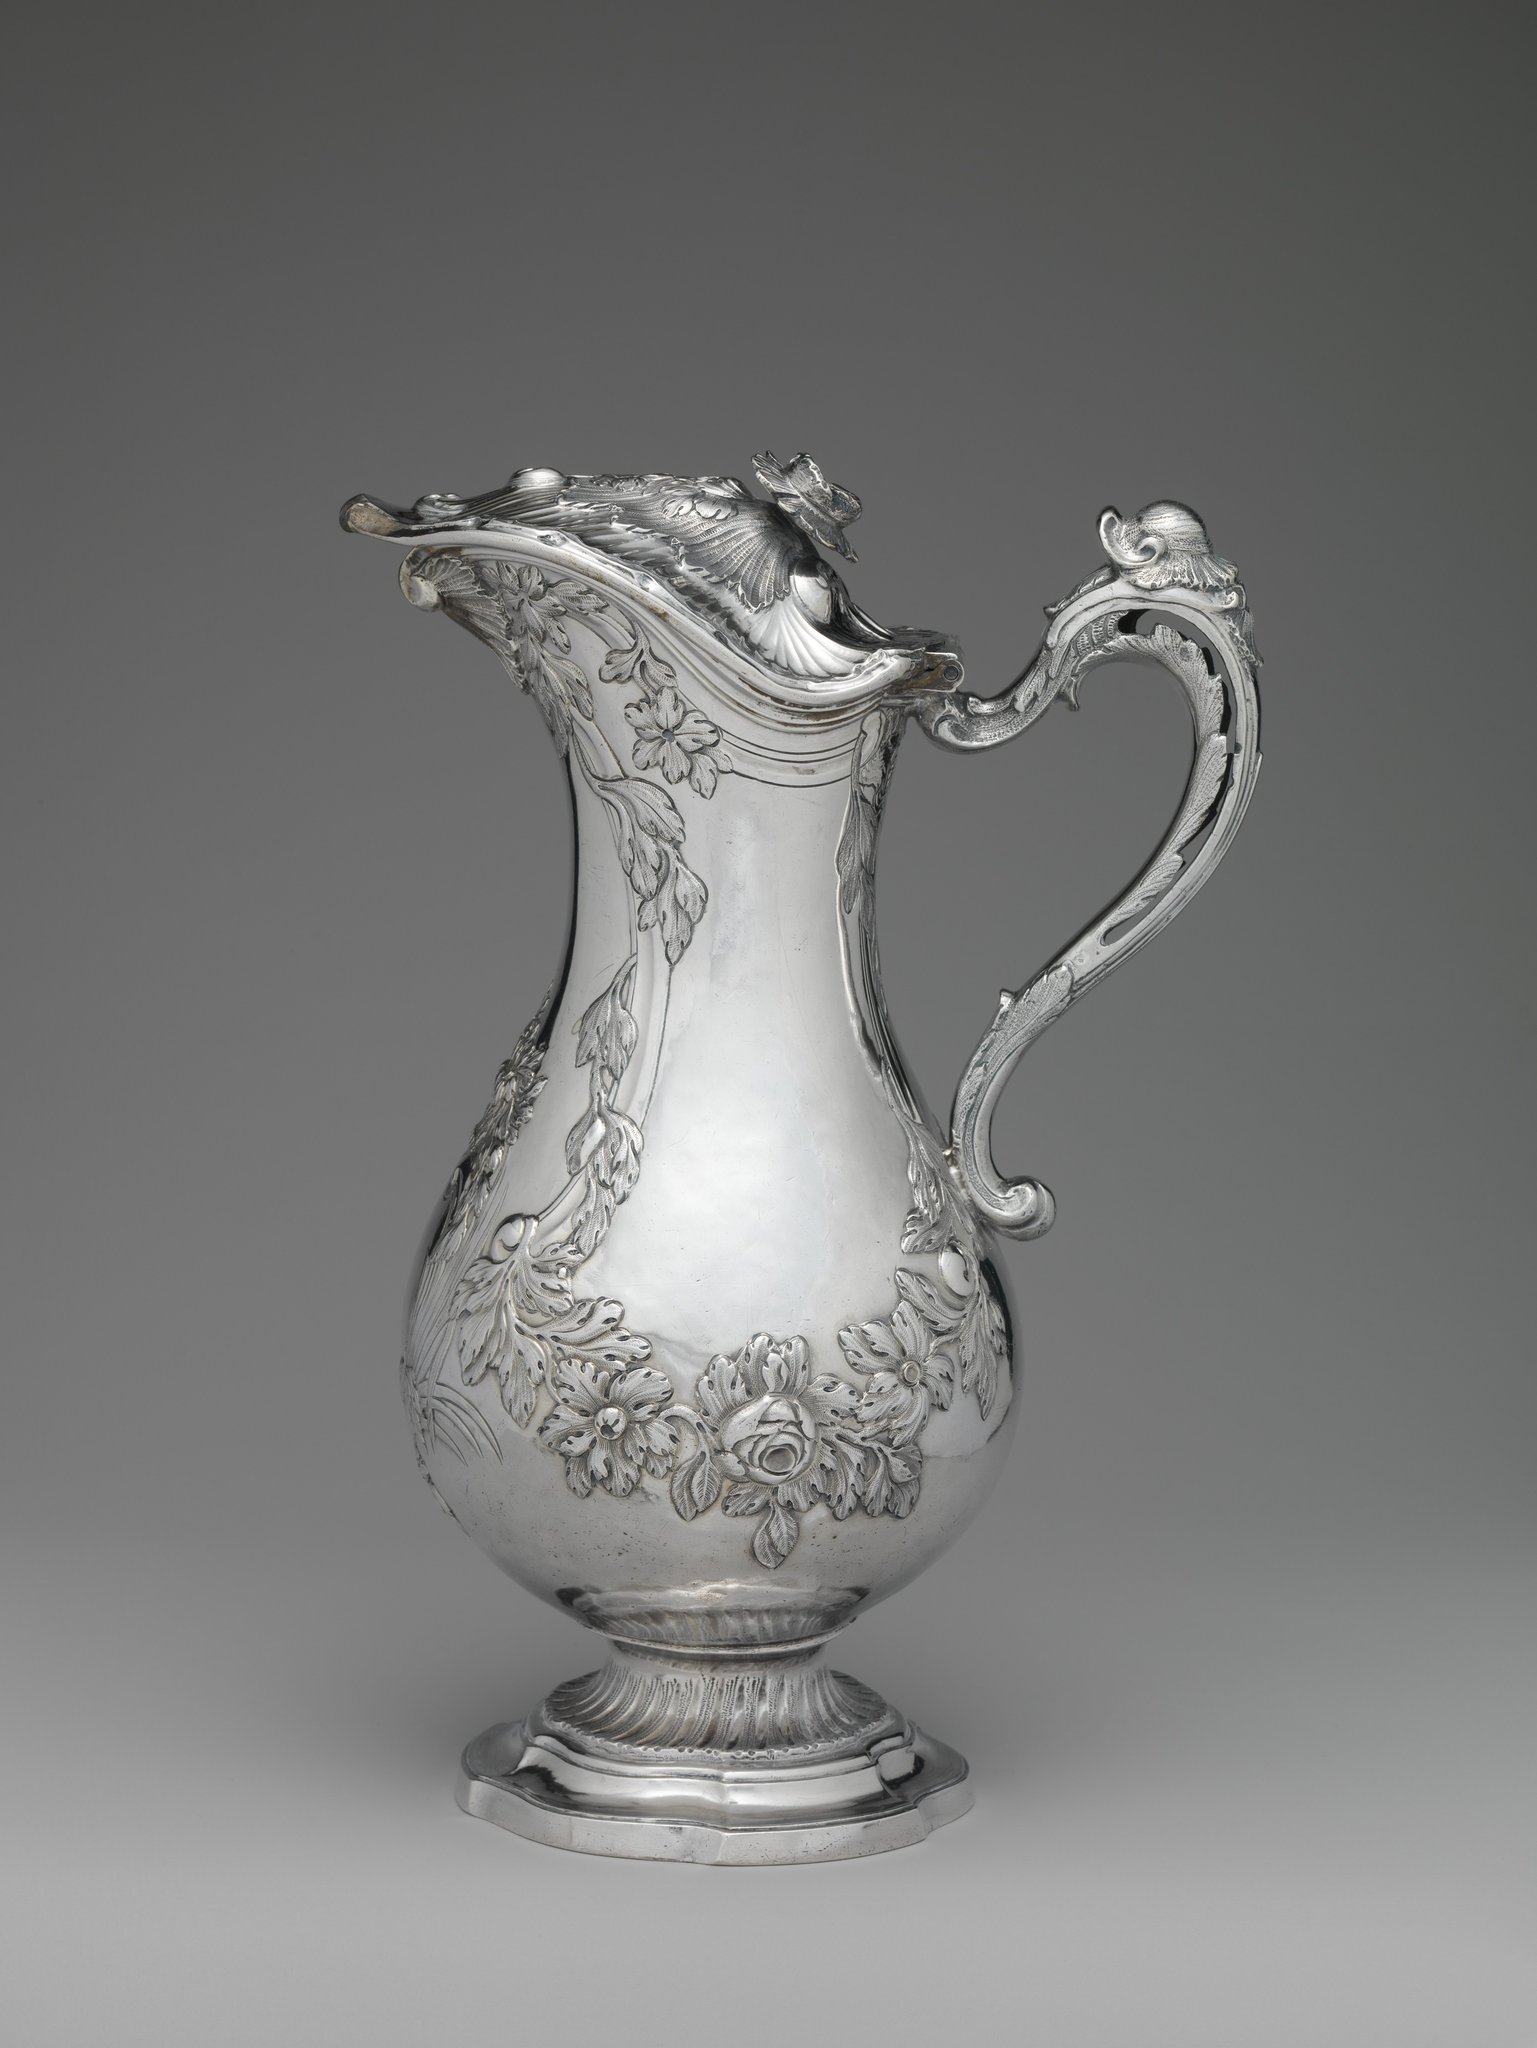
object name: ewer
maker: barthélemy samson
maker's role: maker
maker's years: 1682-1782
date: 1771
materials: silver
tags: flowers